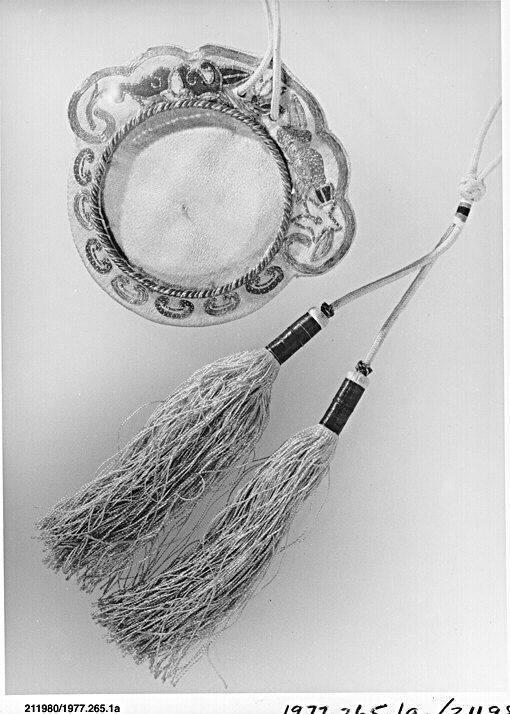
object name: case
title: Three Cases from a Set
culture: chinese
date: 1867-1900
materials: metal thread, silk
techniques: embroidery